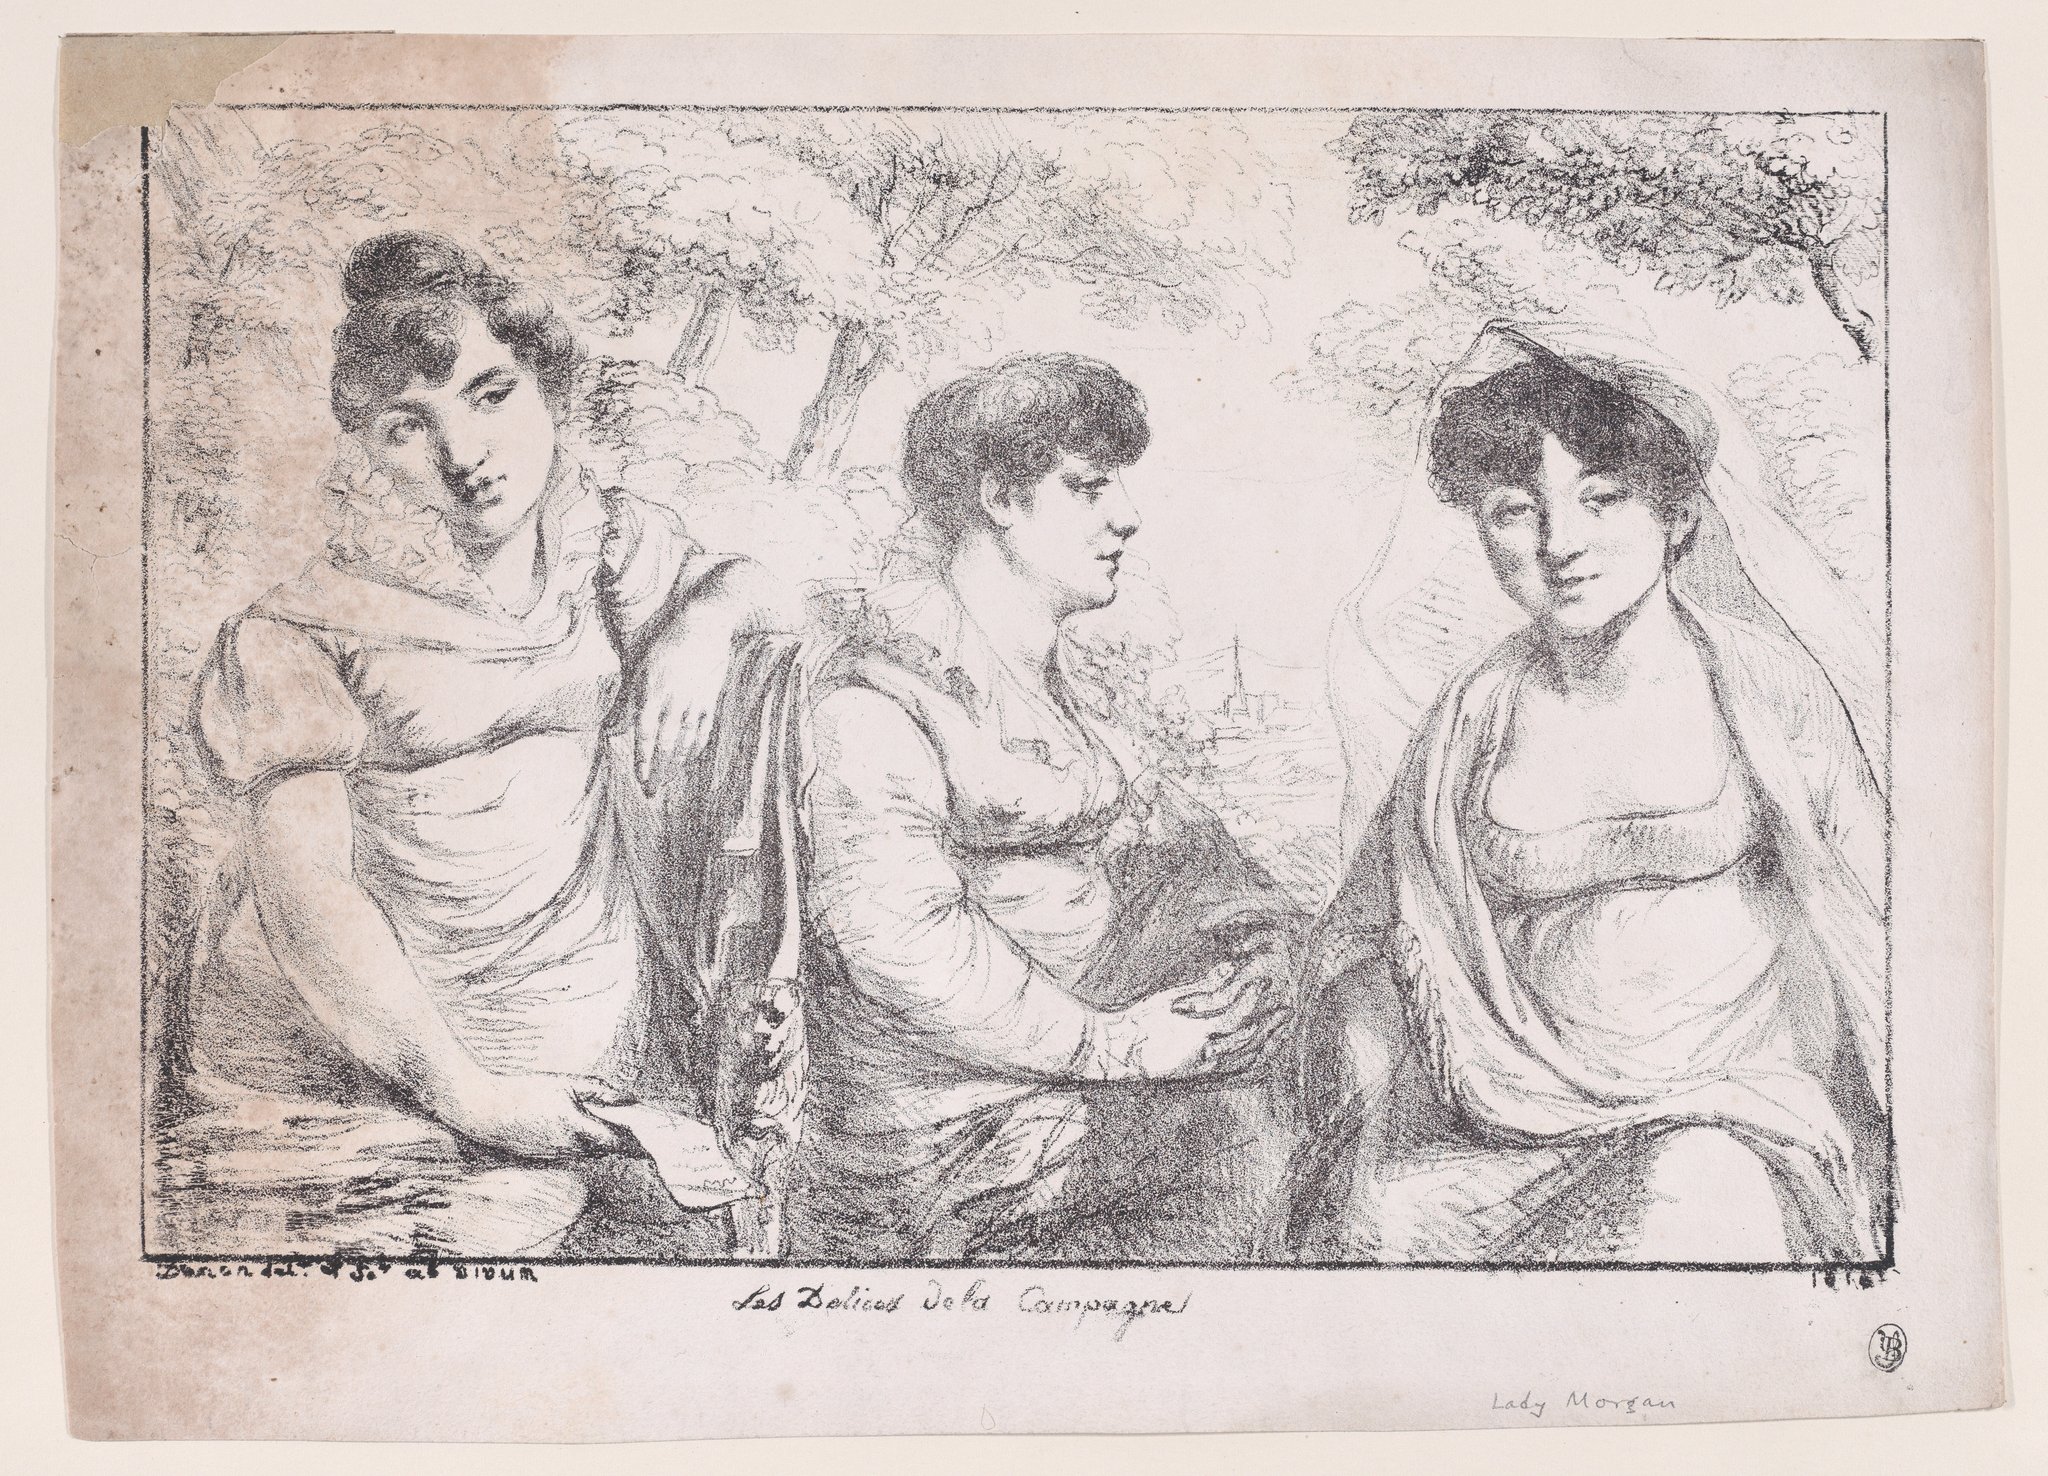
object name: print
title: Delices de la Campagne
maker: baron dominique vivant denon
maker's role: artist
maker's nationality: french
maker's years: 1747-1825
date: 1818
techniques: lithograph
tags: women